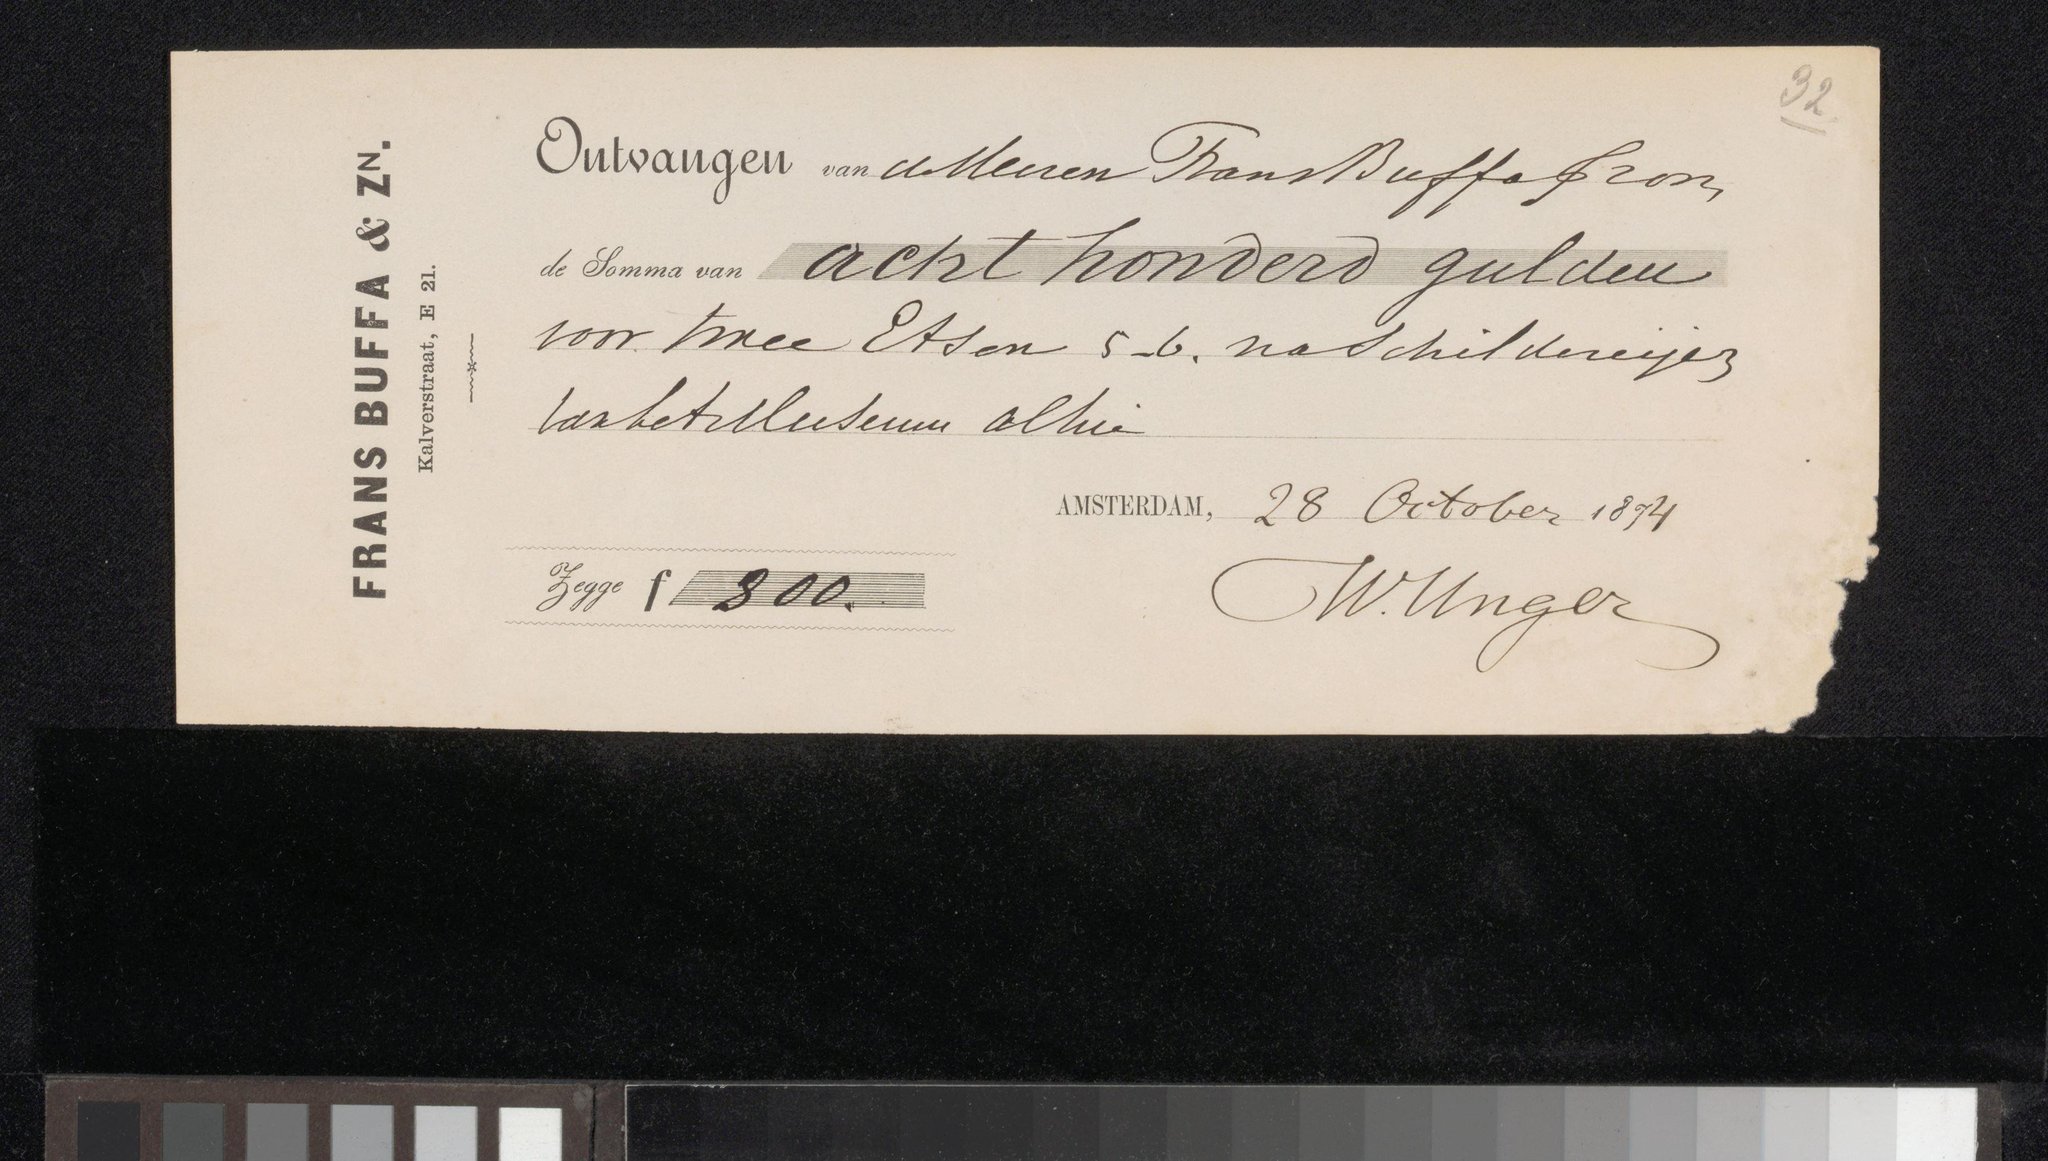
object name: ontvangstbewijs, kwitantie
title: Kwitantie voor William Unger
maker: william unger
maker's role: draughtsman, painter, print maker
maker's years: 1837-1932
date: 1874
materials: ink, paper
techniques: pen, printing, writing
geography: amsterdam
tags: the graphic arts, money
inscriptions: collector's mark: Lugt 2233